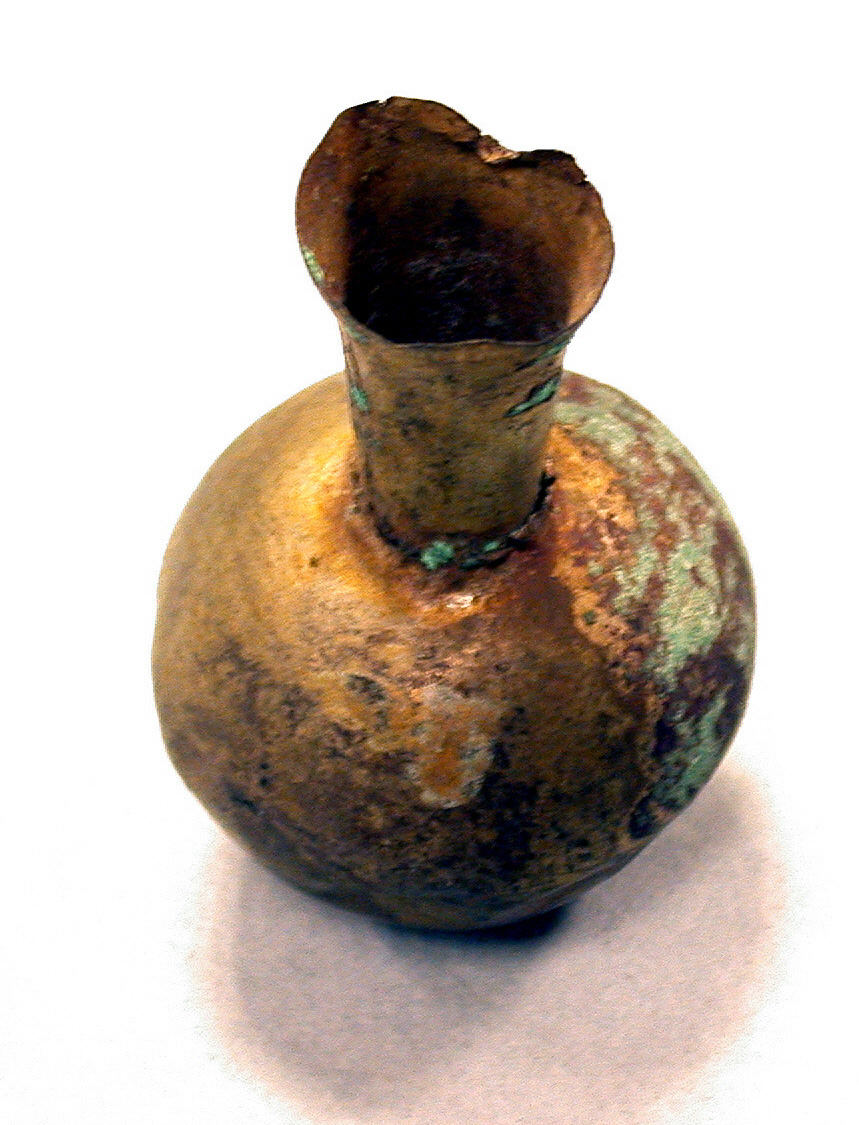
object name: bottle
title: Miniature Bottle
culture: chancay or chimú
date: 1001-1500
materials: copper, silver gilt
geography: peru